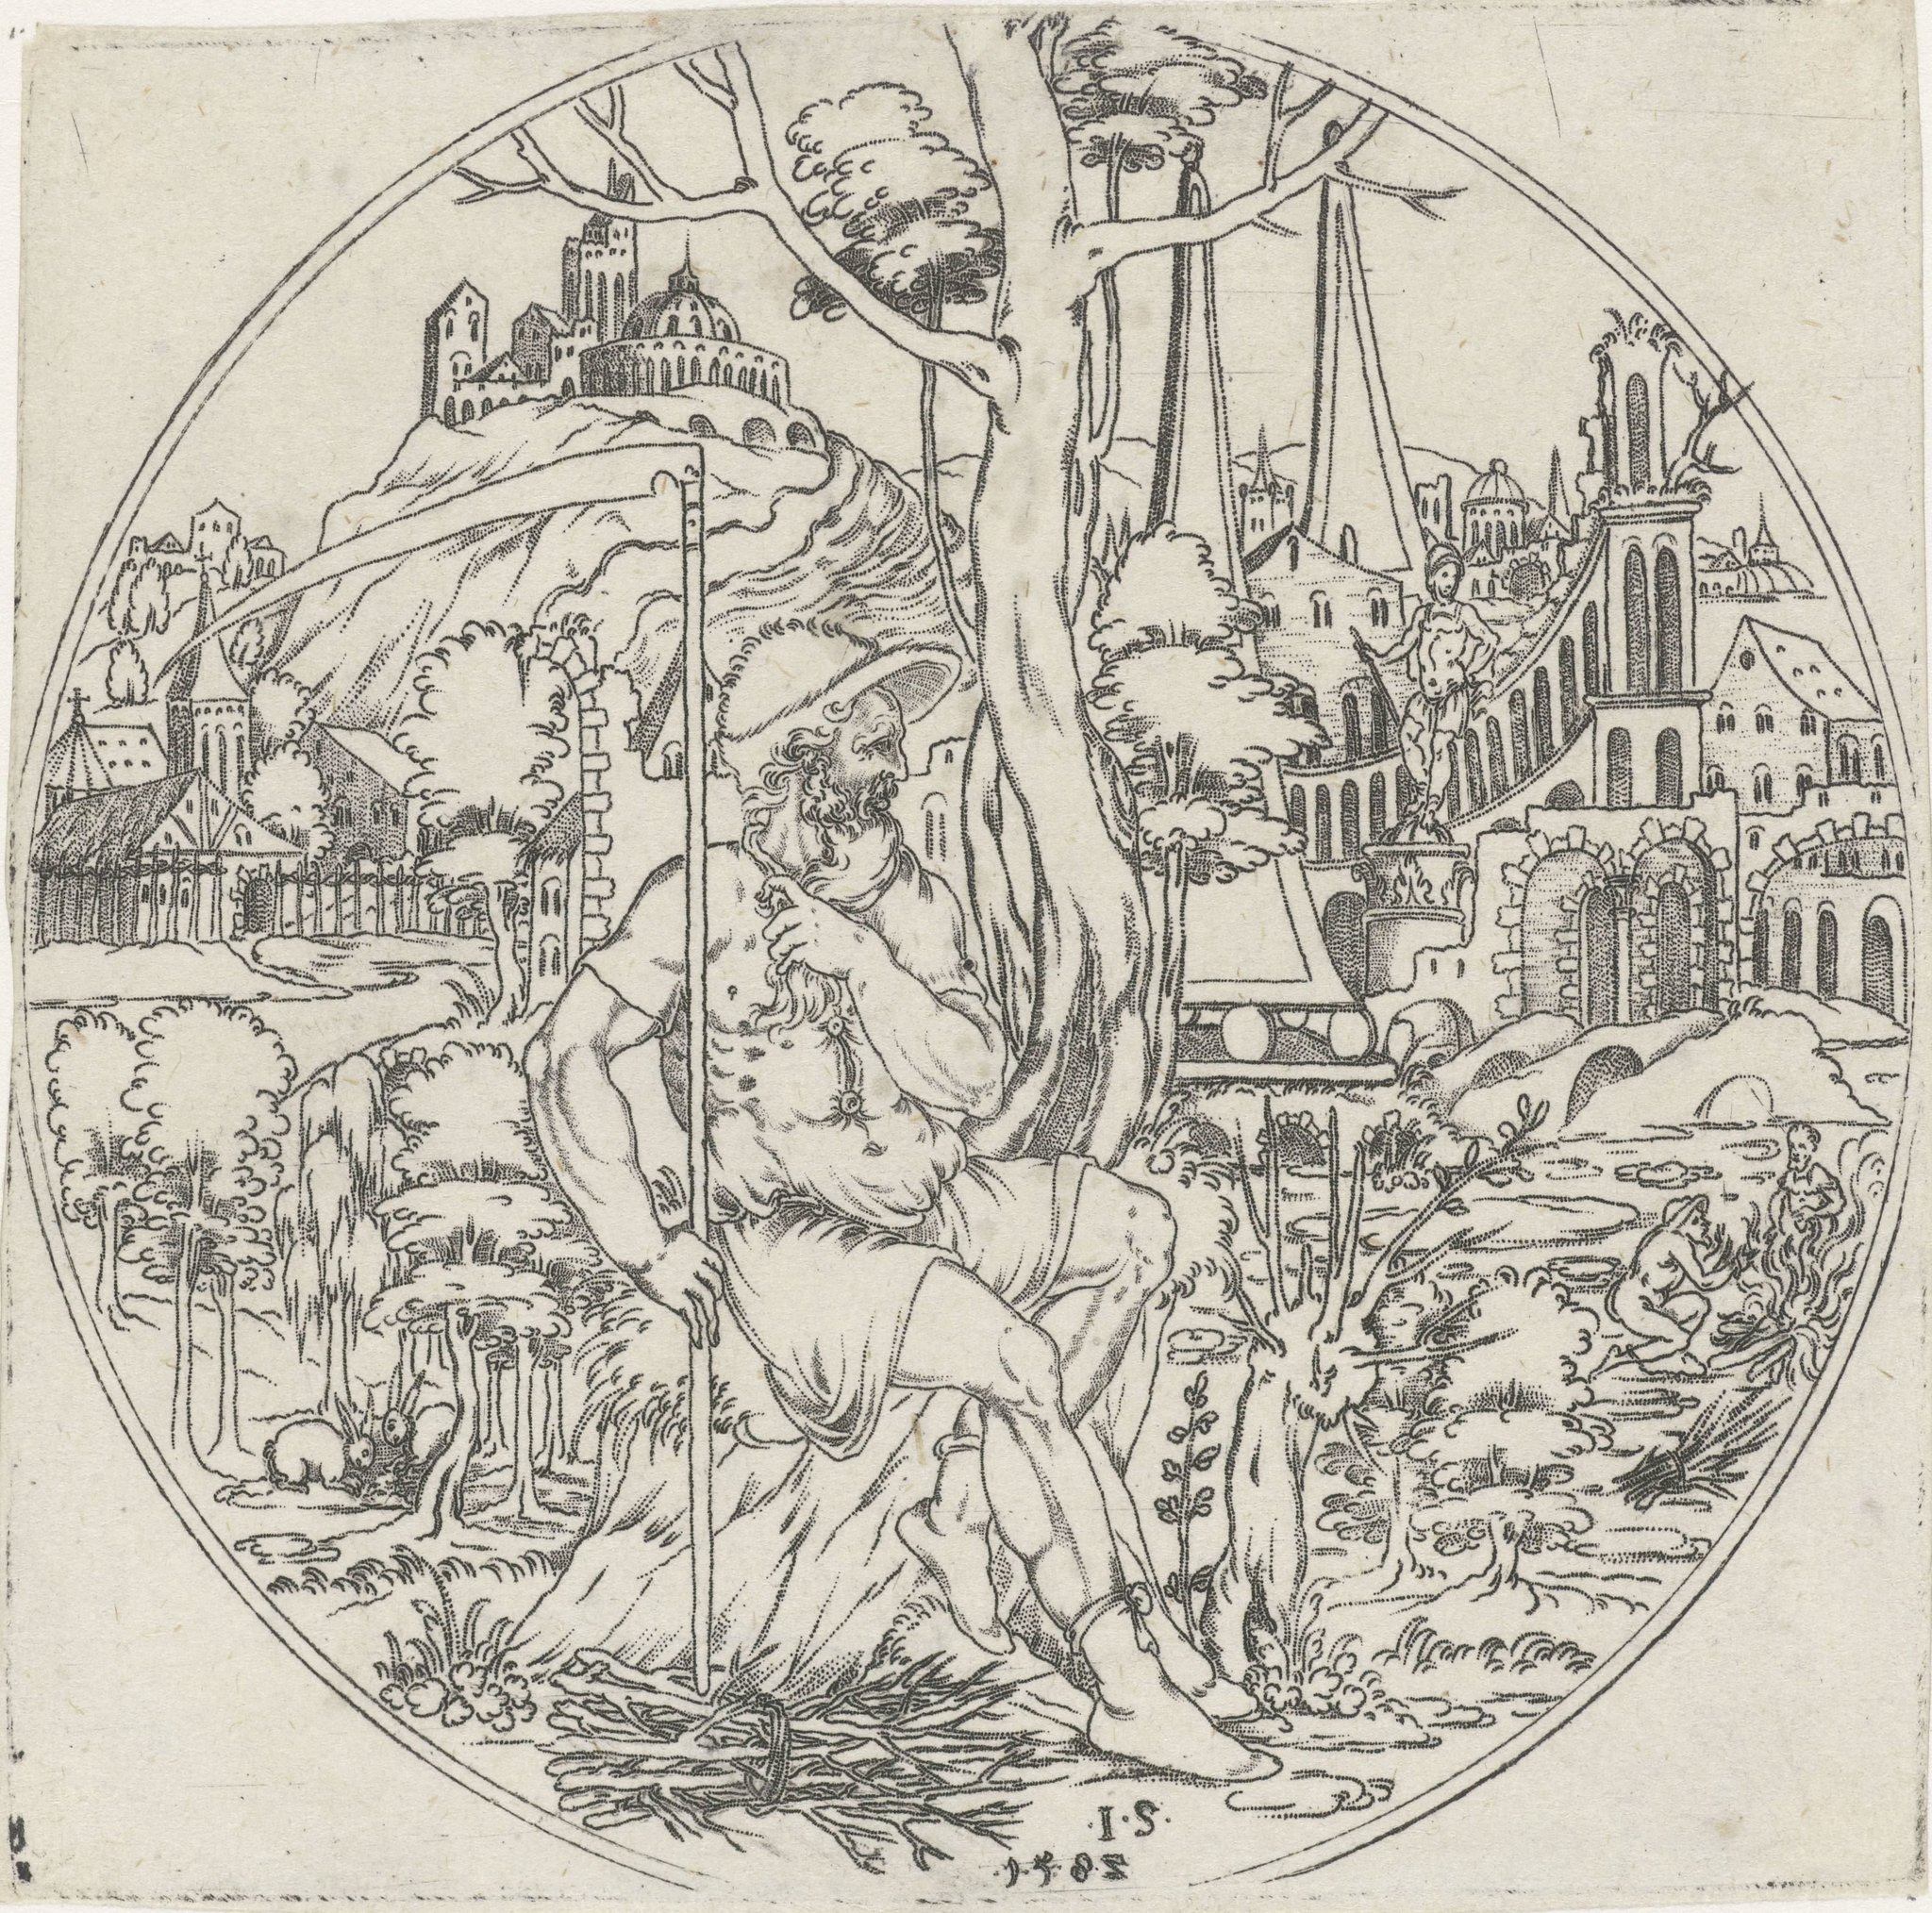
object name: print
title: Bodems van schalen: landschappen met bijbelse en mythologische voorstellingen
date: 1572-1582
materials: paper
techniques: engraving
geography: germany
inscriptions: collector's mark: Lugt 240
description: Saturnus gezeten op een steen aan de voet van een boom. Hij heeft zijn zeis in zijn hand. Uit serie van 8 bladen?